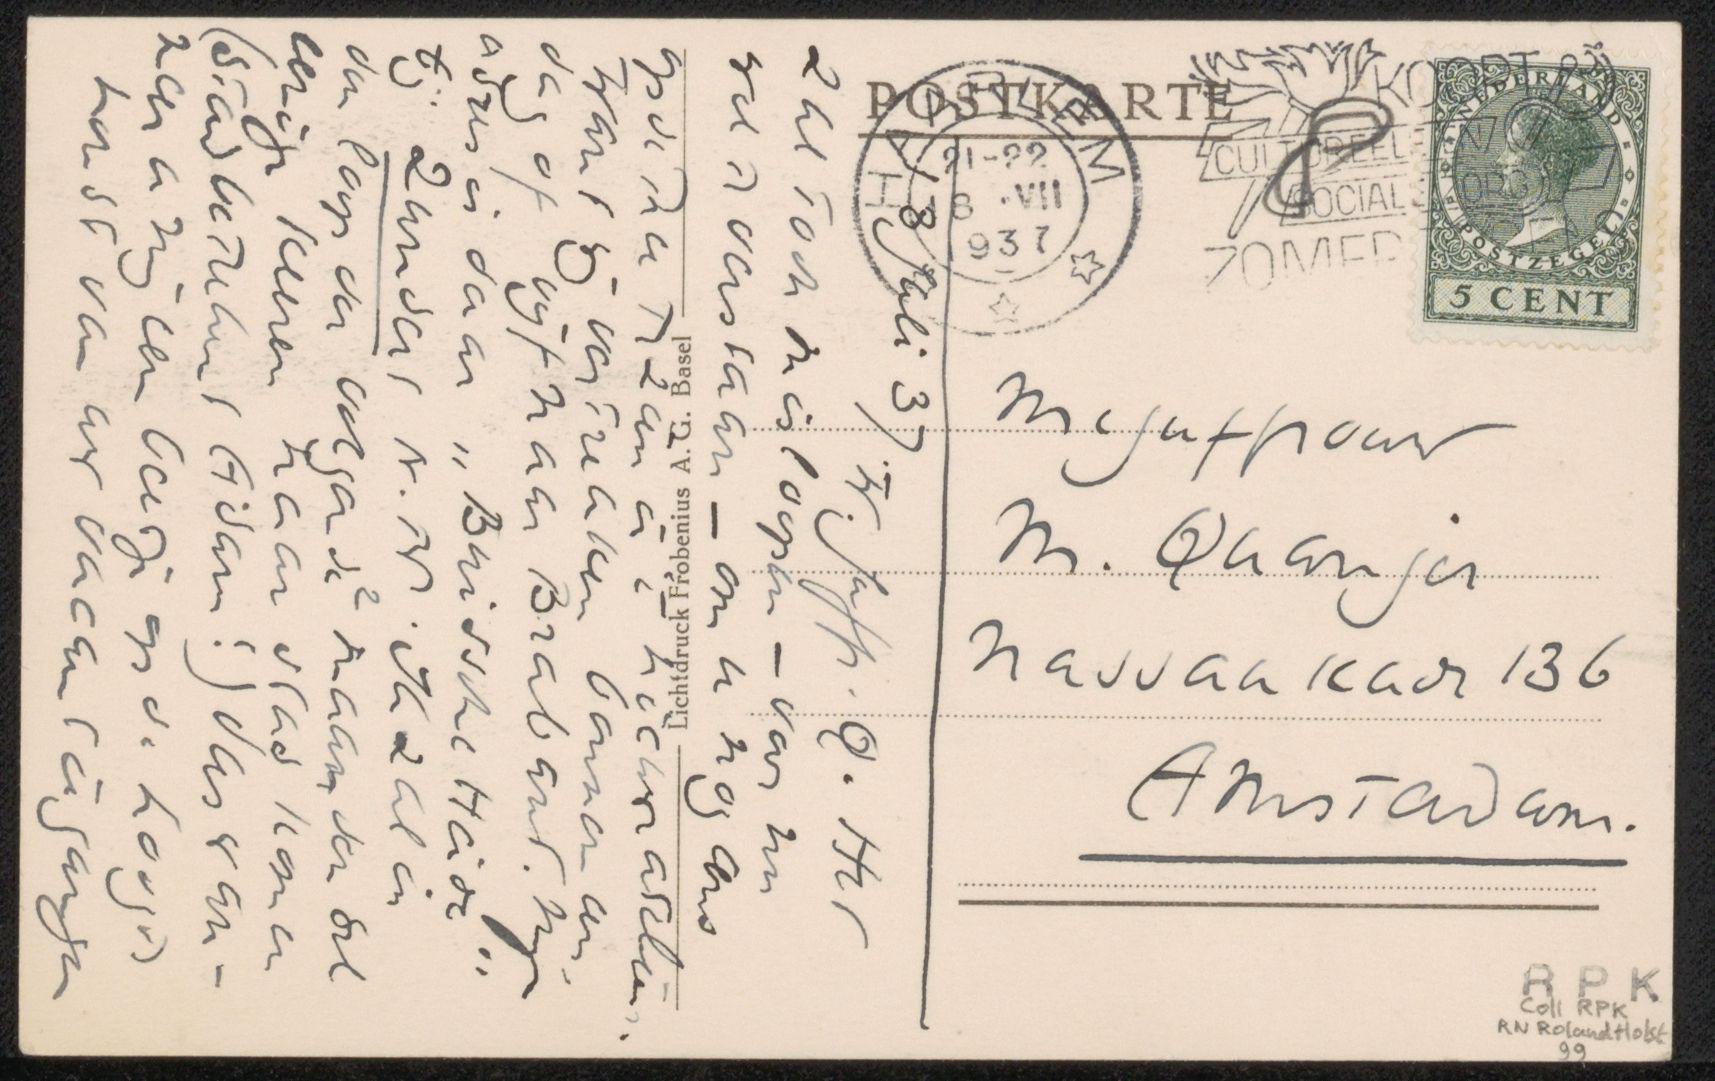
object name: ansichtkaart, prentbriefkaart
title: Prentbriefkaart aan Marisa Quanjer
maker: richard nicolaüs roland holst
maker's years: 1868-1938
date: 1937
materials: cardboard, ink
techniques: photograph, pen, writing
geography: haarlem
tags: historicus, kunsthistoricus, marisa quanjer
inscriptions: collector's mark: ‘RPK’